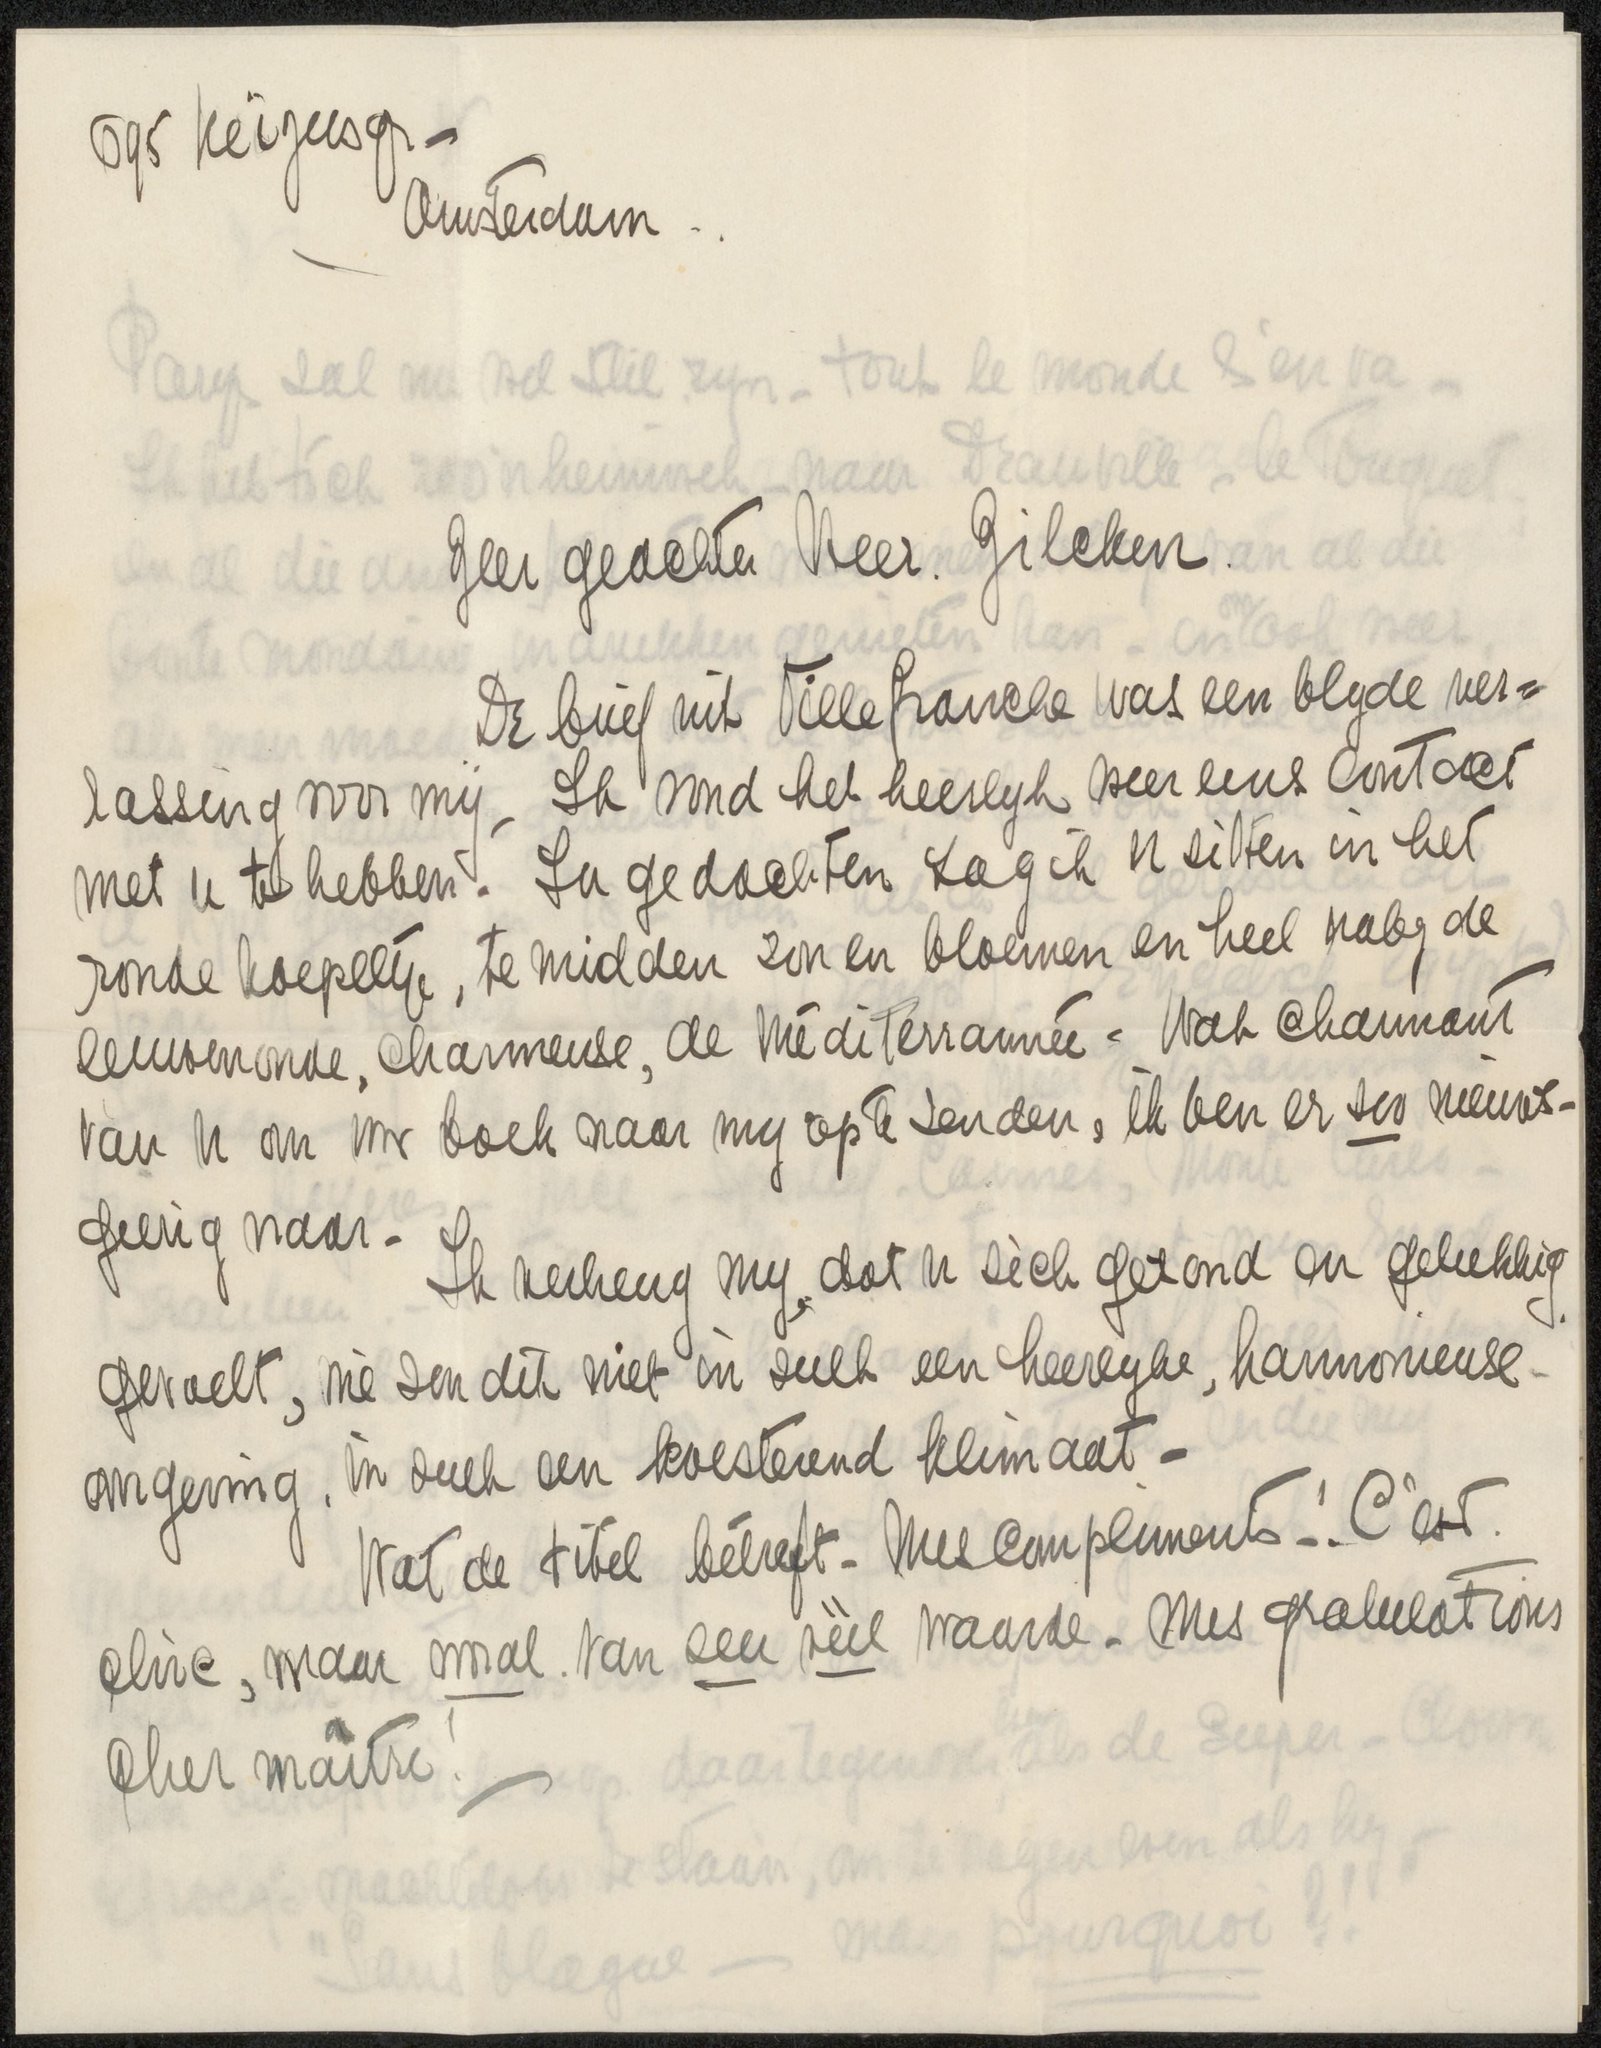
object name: letter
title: Brief aan Philip Zilcken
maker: bobette van gelder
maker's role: draughtsman, painter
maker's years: 1891-1945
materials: ink, paper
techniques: pen, writing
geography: amsterdam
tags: philip zilcken, drawing, family life, travelling; tourism, printed matter, paris